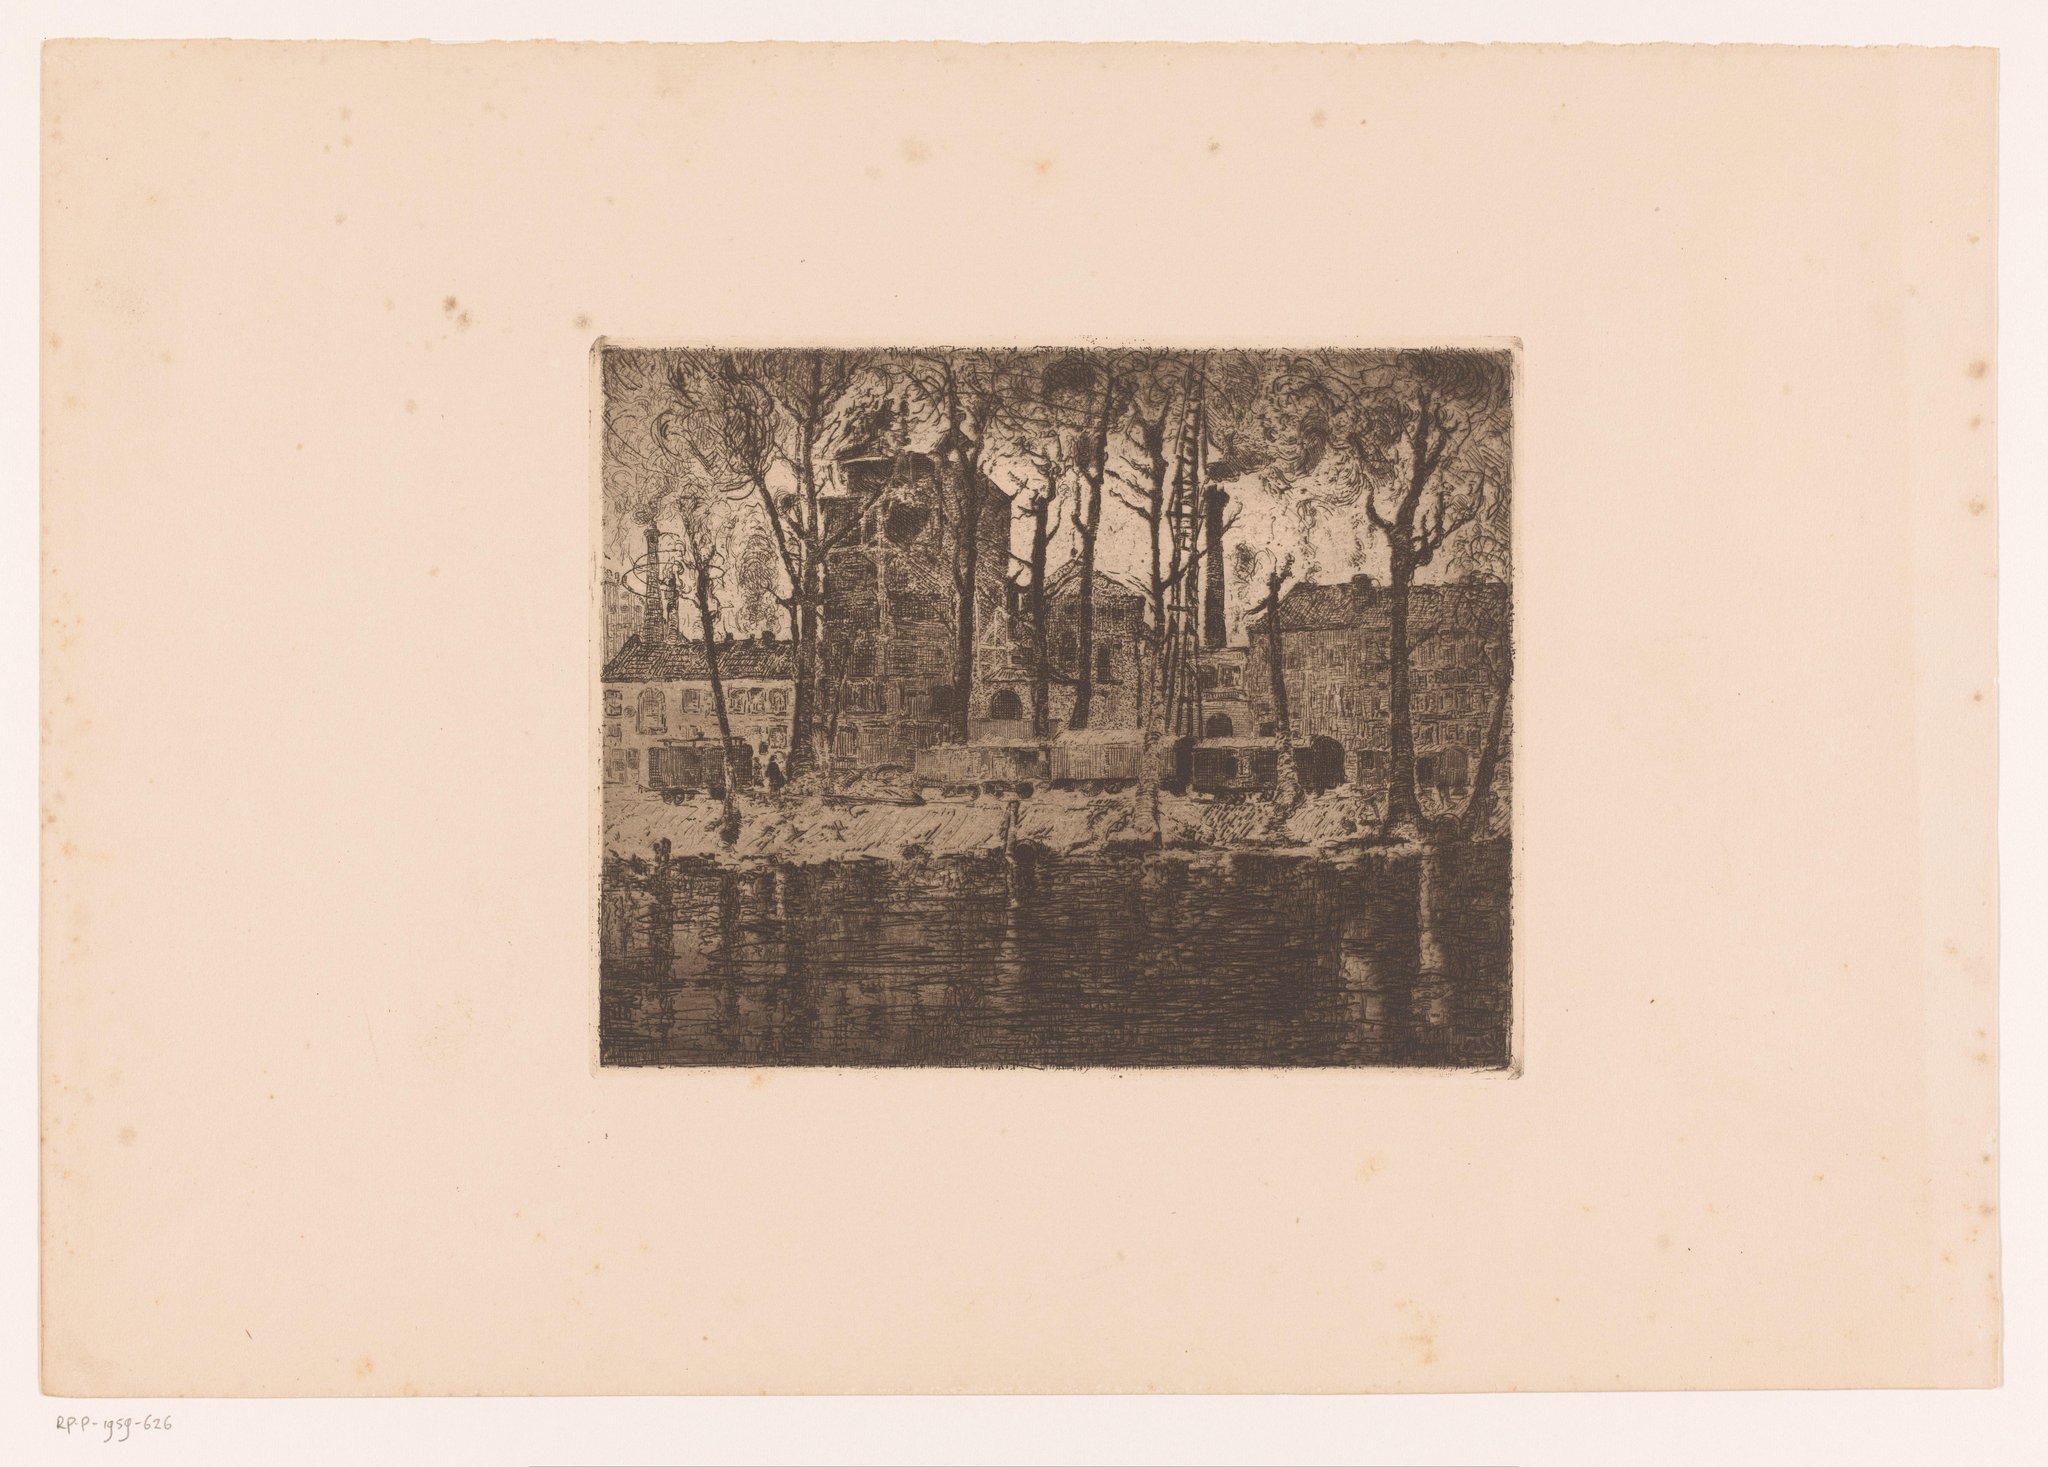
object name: print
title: Gezicht op een fabriek aan het water na een brand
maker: marcel jefferys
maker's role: print maker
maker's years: 1872-1924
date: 1882-1924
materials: paper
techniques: etching, intaglio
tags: railway-coach, railway-carriage, wagon, factory in landscape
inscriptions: collector's mark: Lugt 2760, collector's mark: Lugt 2228